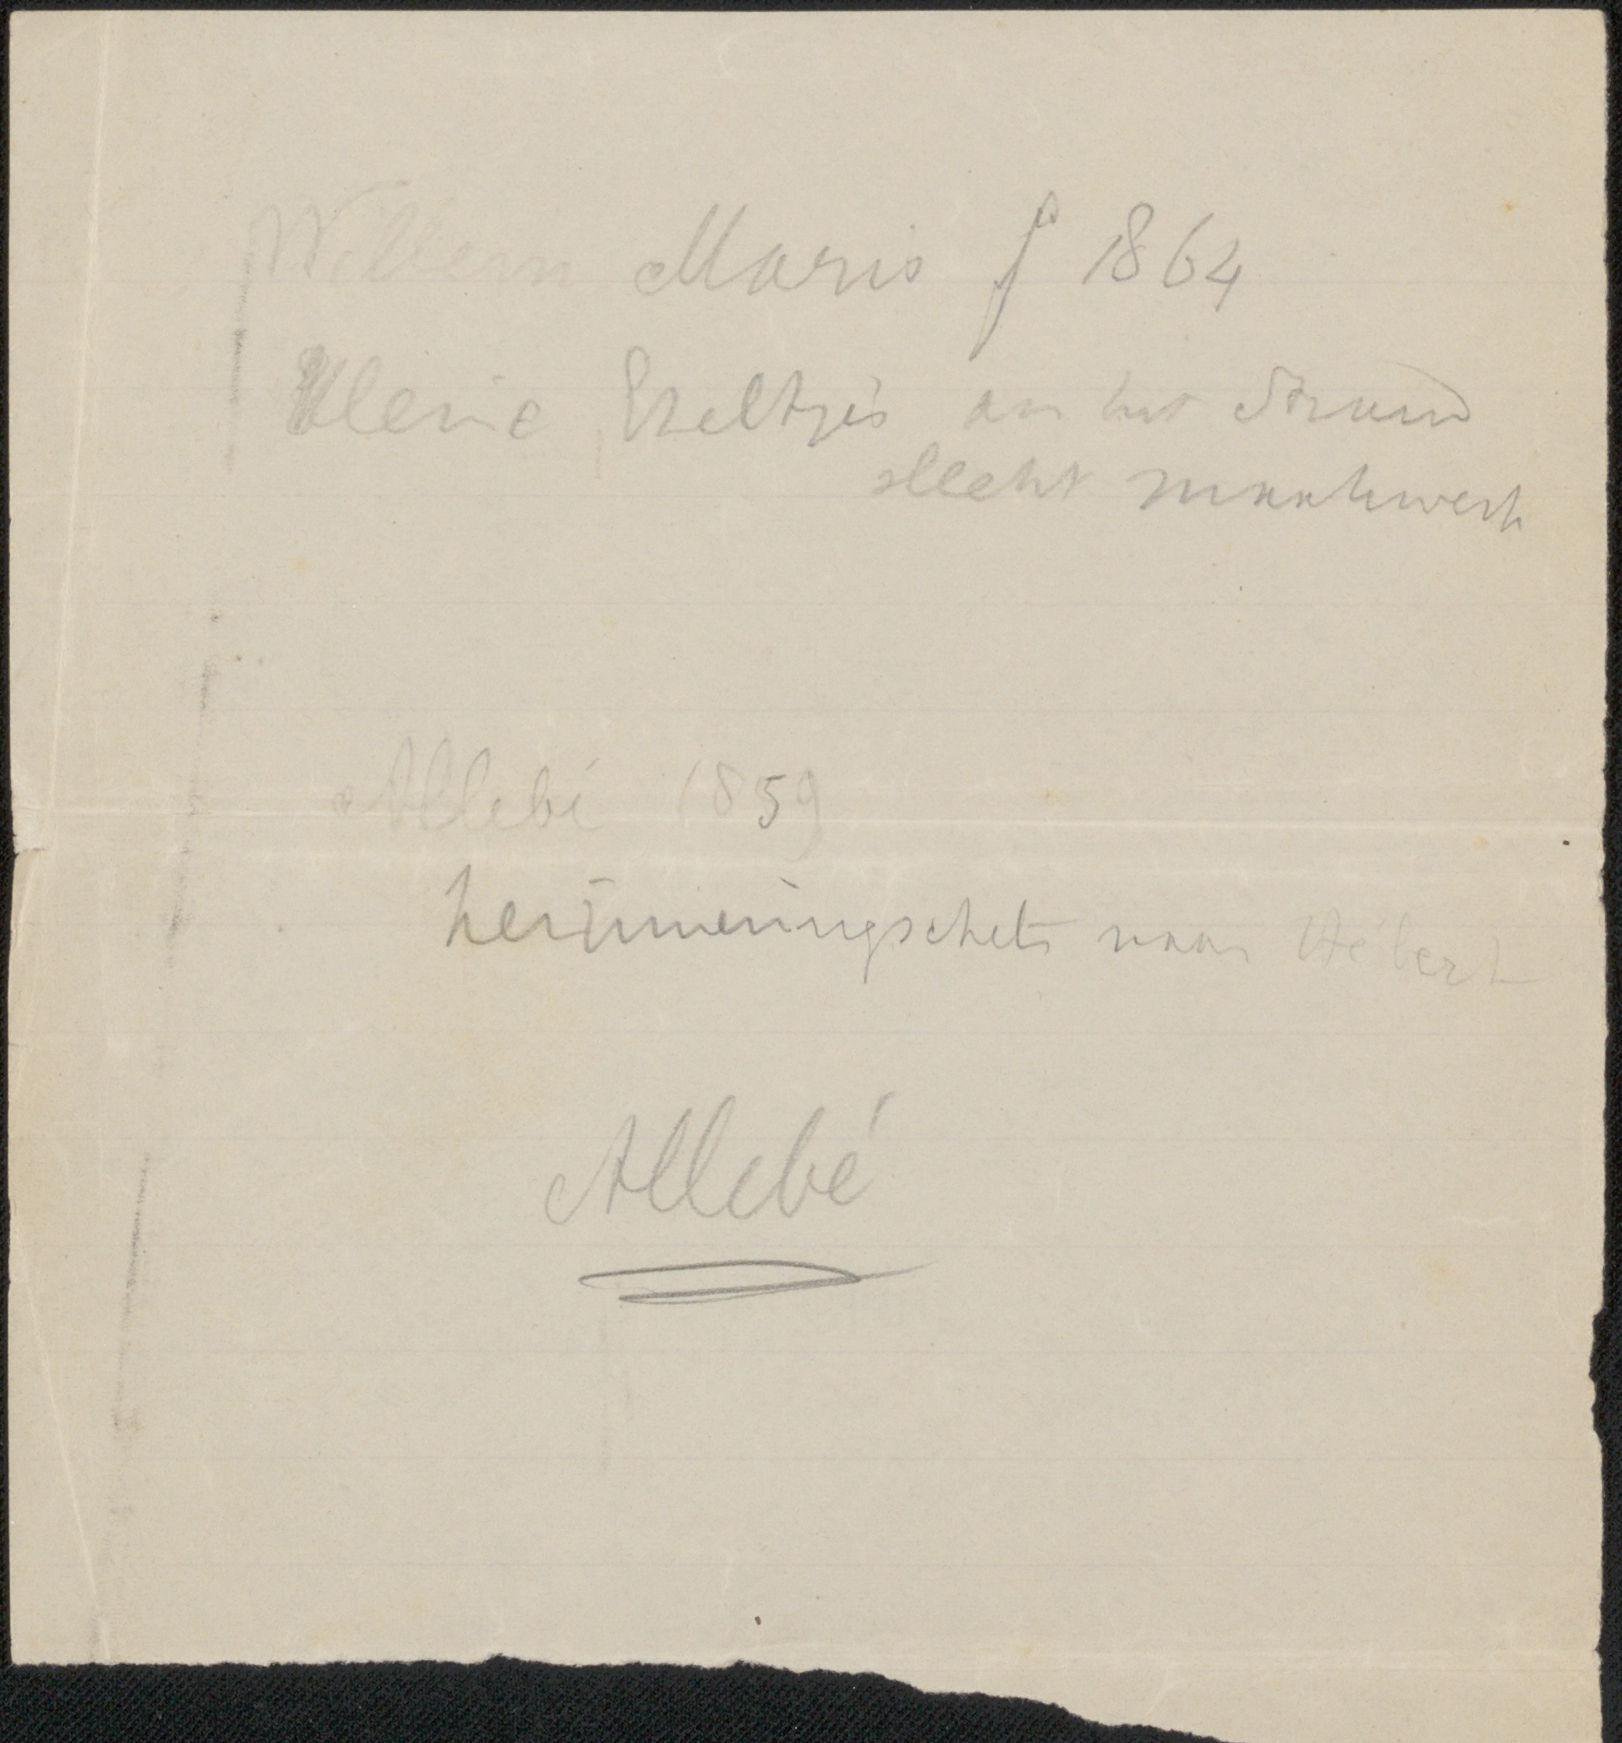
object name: aantekening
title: Aantekening uit archief Jan Veth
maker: Anonymous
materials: pencil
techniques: writing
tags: amsterdam, print maker, august allebé, designer, jan veth, the hague, painter, draughtsman, willem maris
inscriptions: collector's mark: ‘RPK’